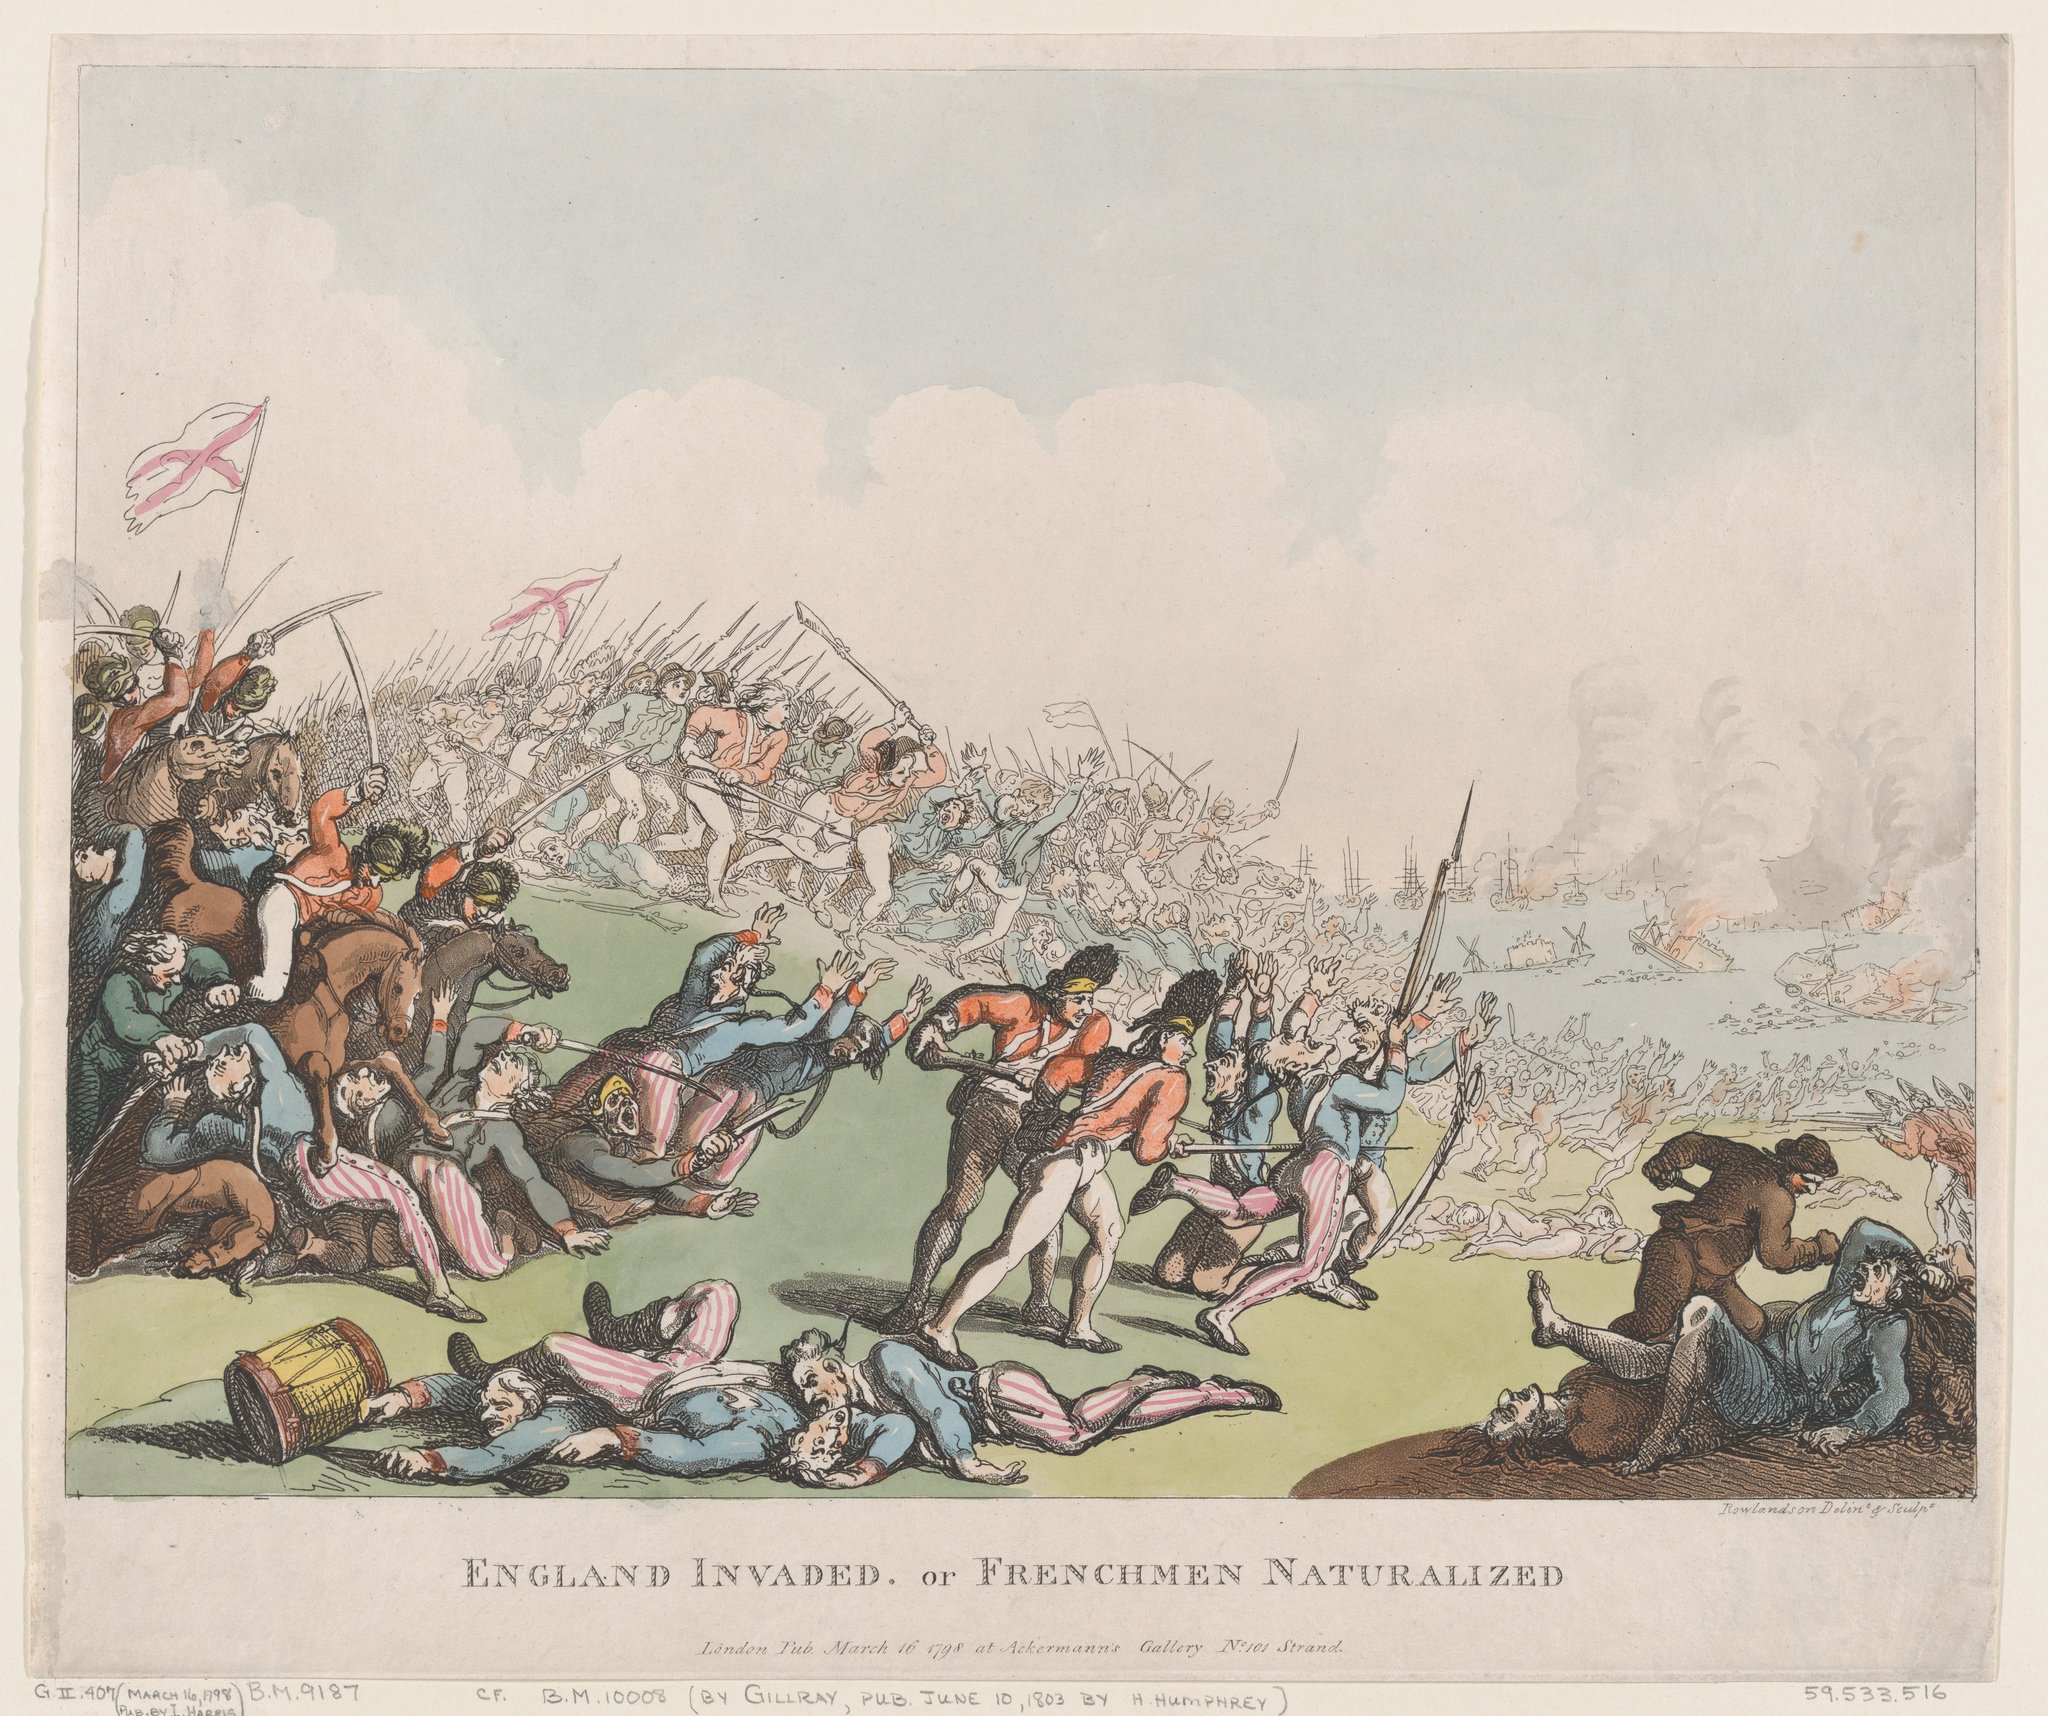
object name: print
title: England Invaded, or Frenchmen Naturalized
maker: thomas rowlandson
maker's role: artist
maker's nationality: british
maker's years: 1757-1827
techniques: aquatint, etching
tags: battles,soldiers,death